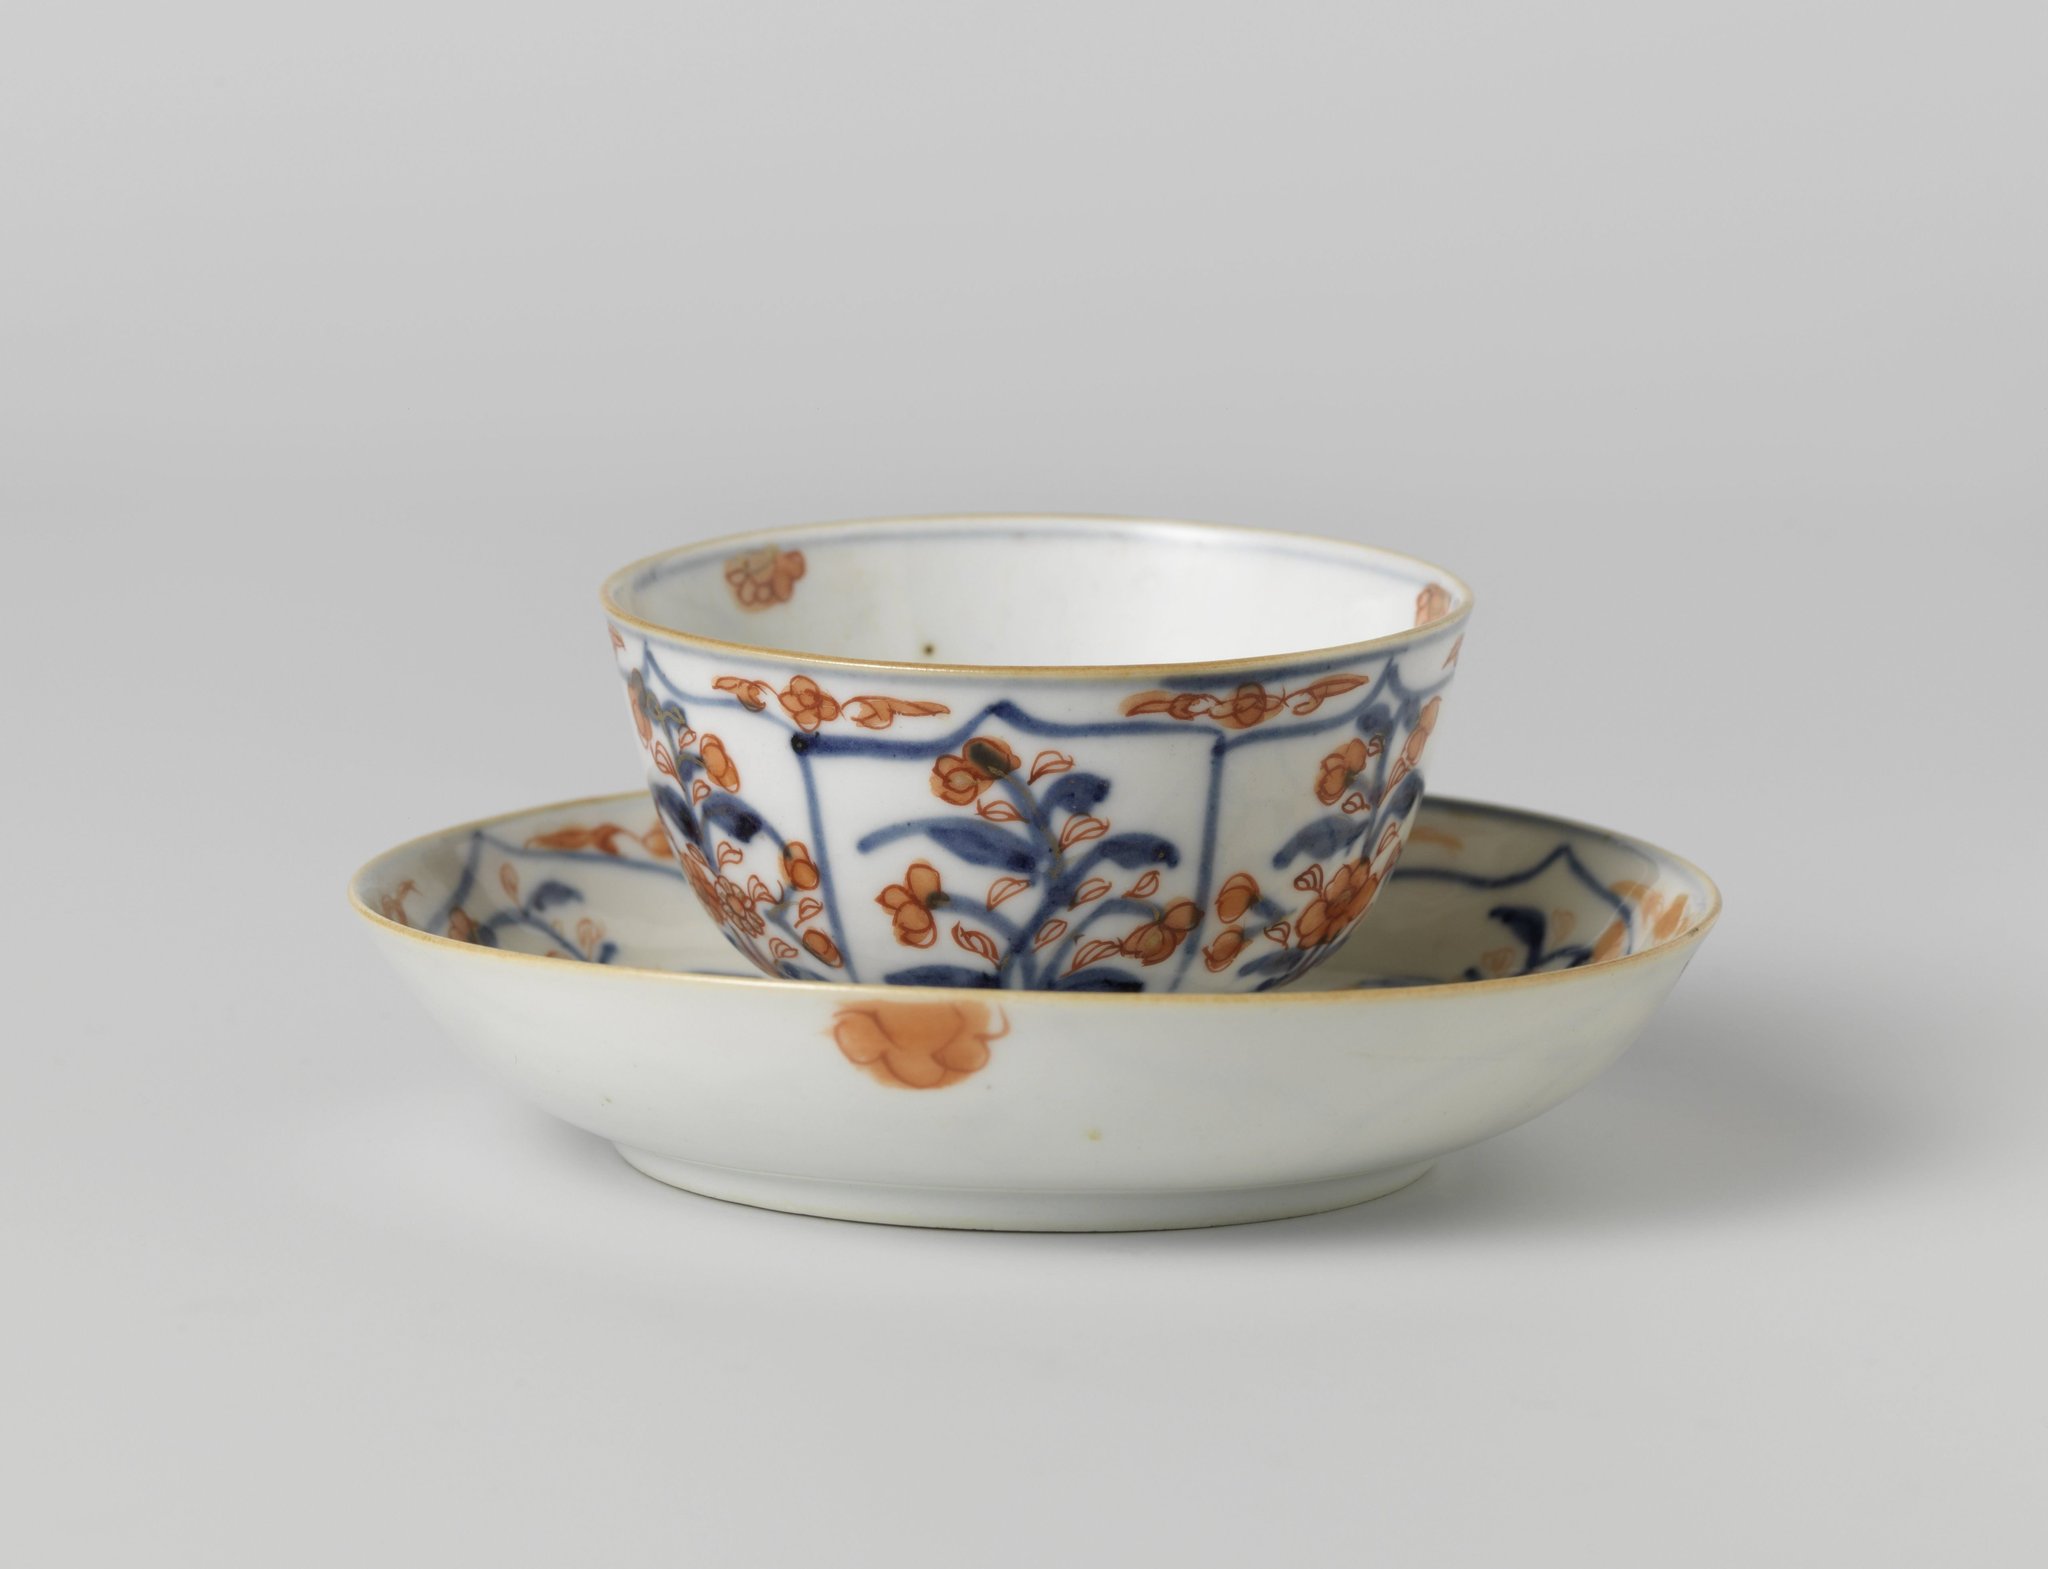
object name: kop en schotel, kop en schotel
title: Cup and saucer with petal-shaped panel around a central medallion, filled with flower sprays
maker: Anonymous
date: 1750-1774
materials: cobalt, glaze, gold, paint, porcelain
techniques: firing, gilding, turning, vitrification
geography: china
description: Imari. Beschilderd met vakken waarin takjes in blauw, rood en goud.